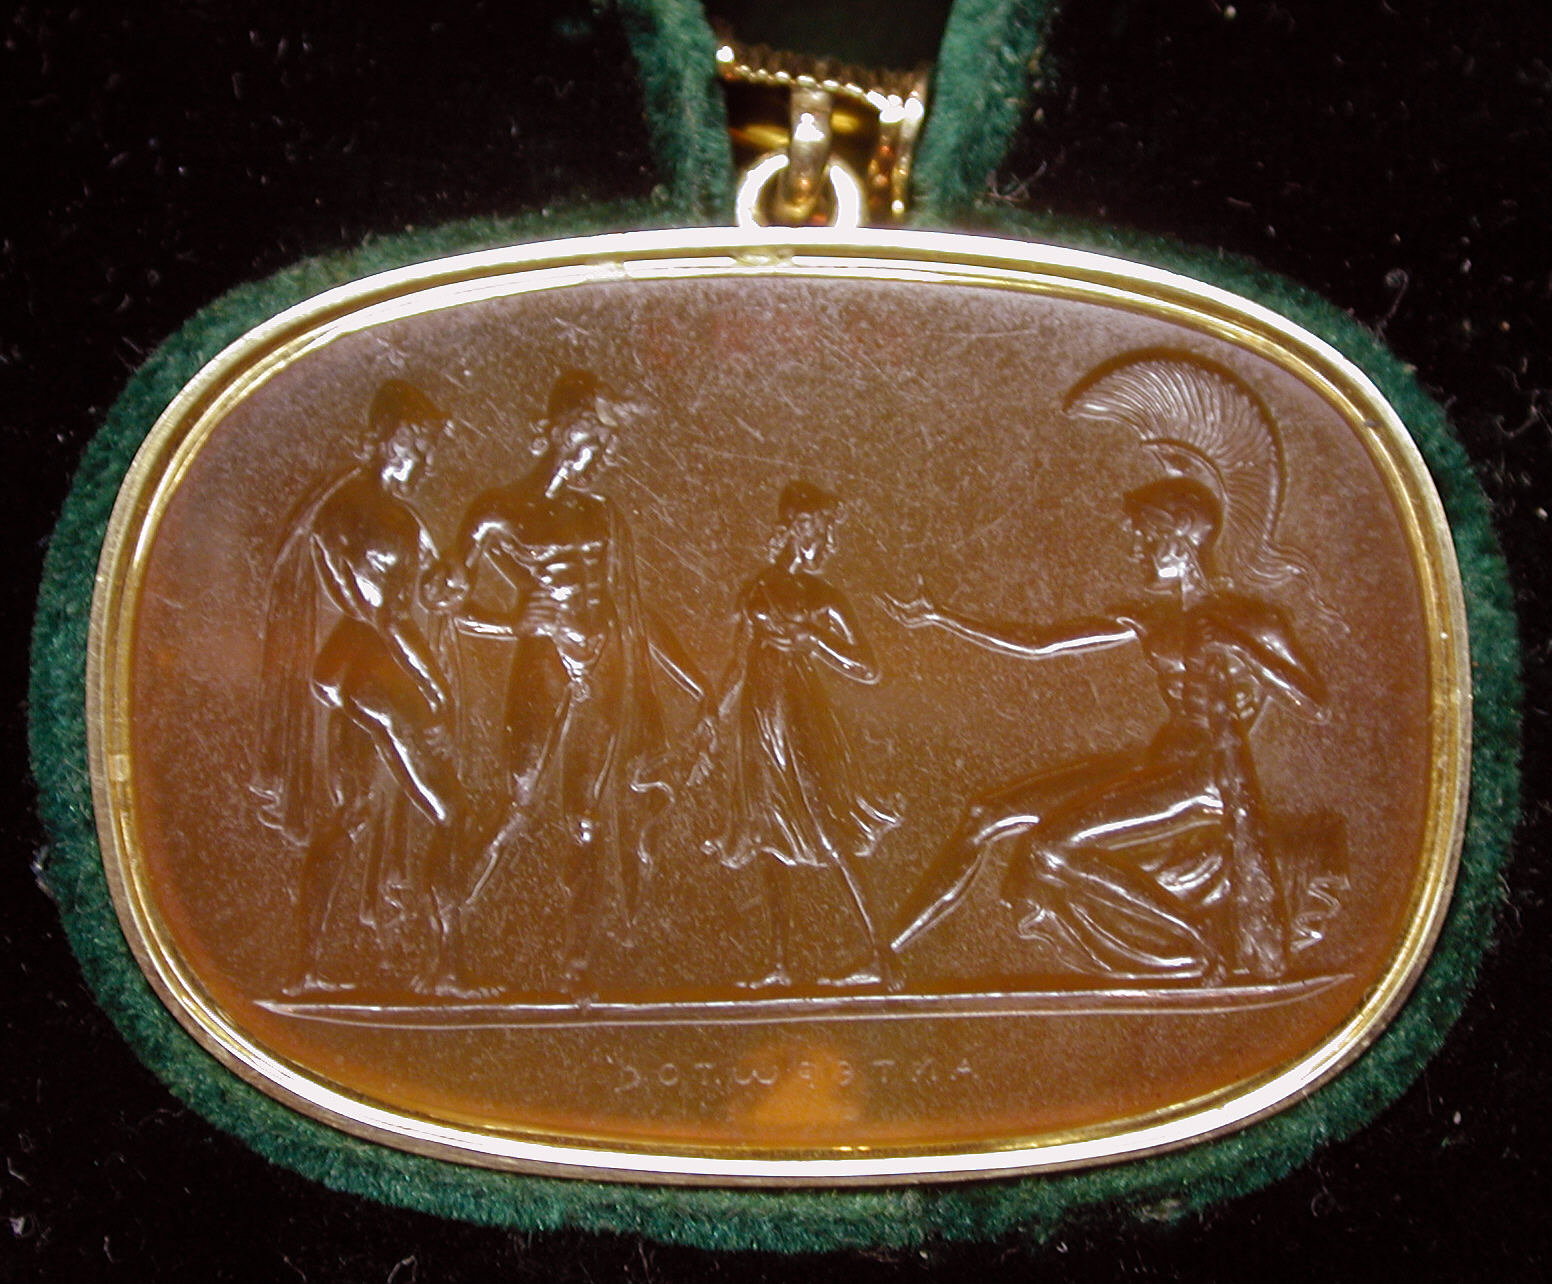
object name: intaglio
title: Theseus restoring Helen to the brothers Castor and Pollux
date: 1801-1833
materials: gemstone, gold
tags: helen,theseus